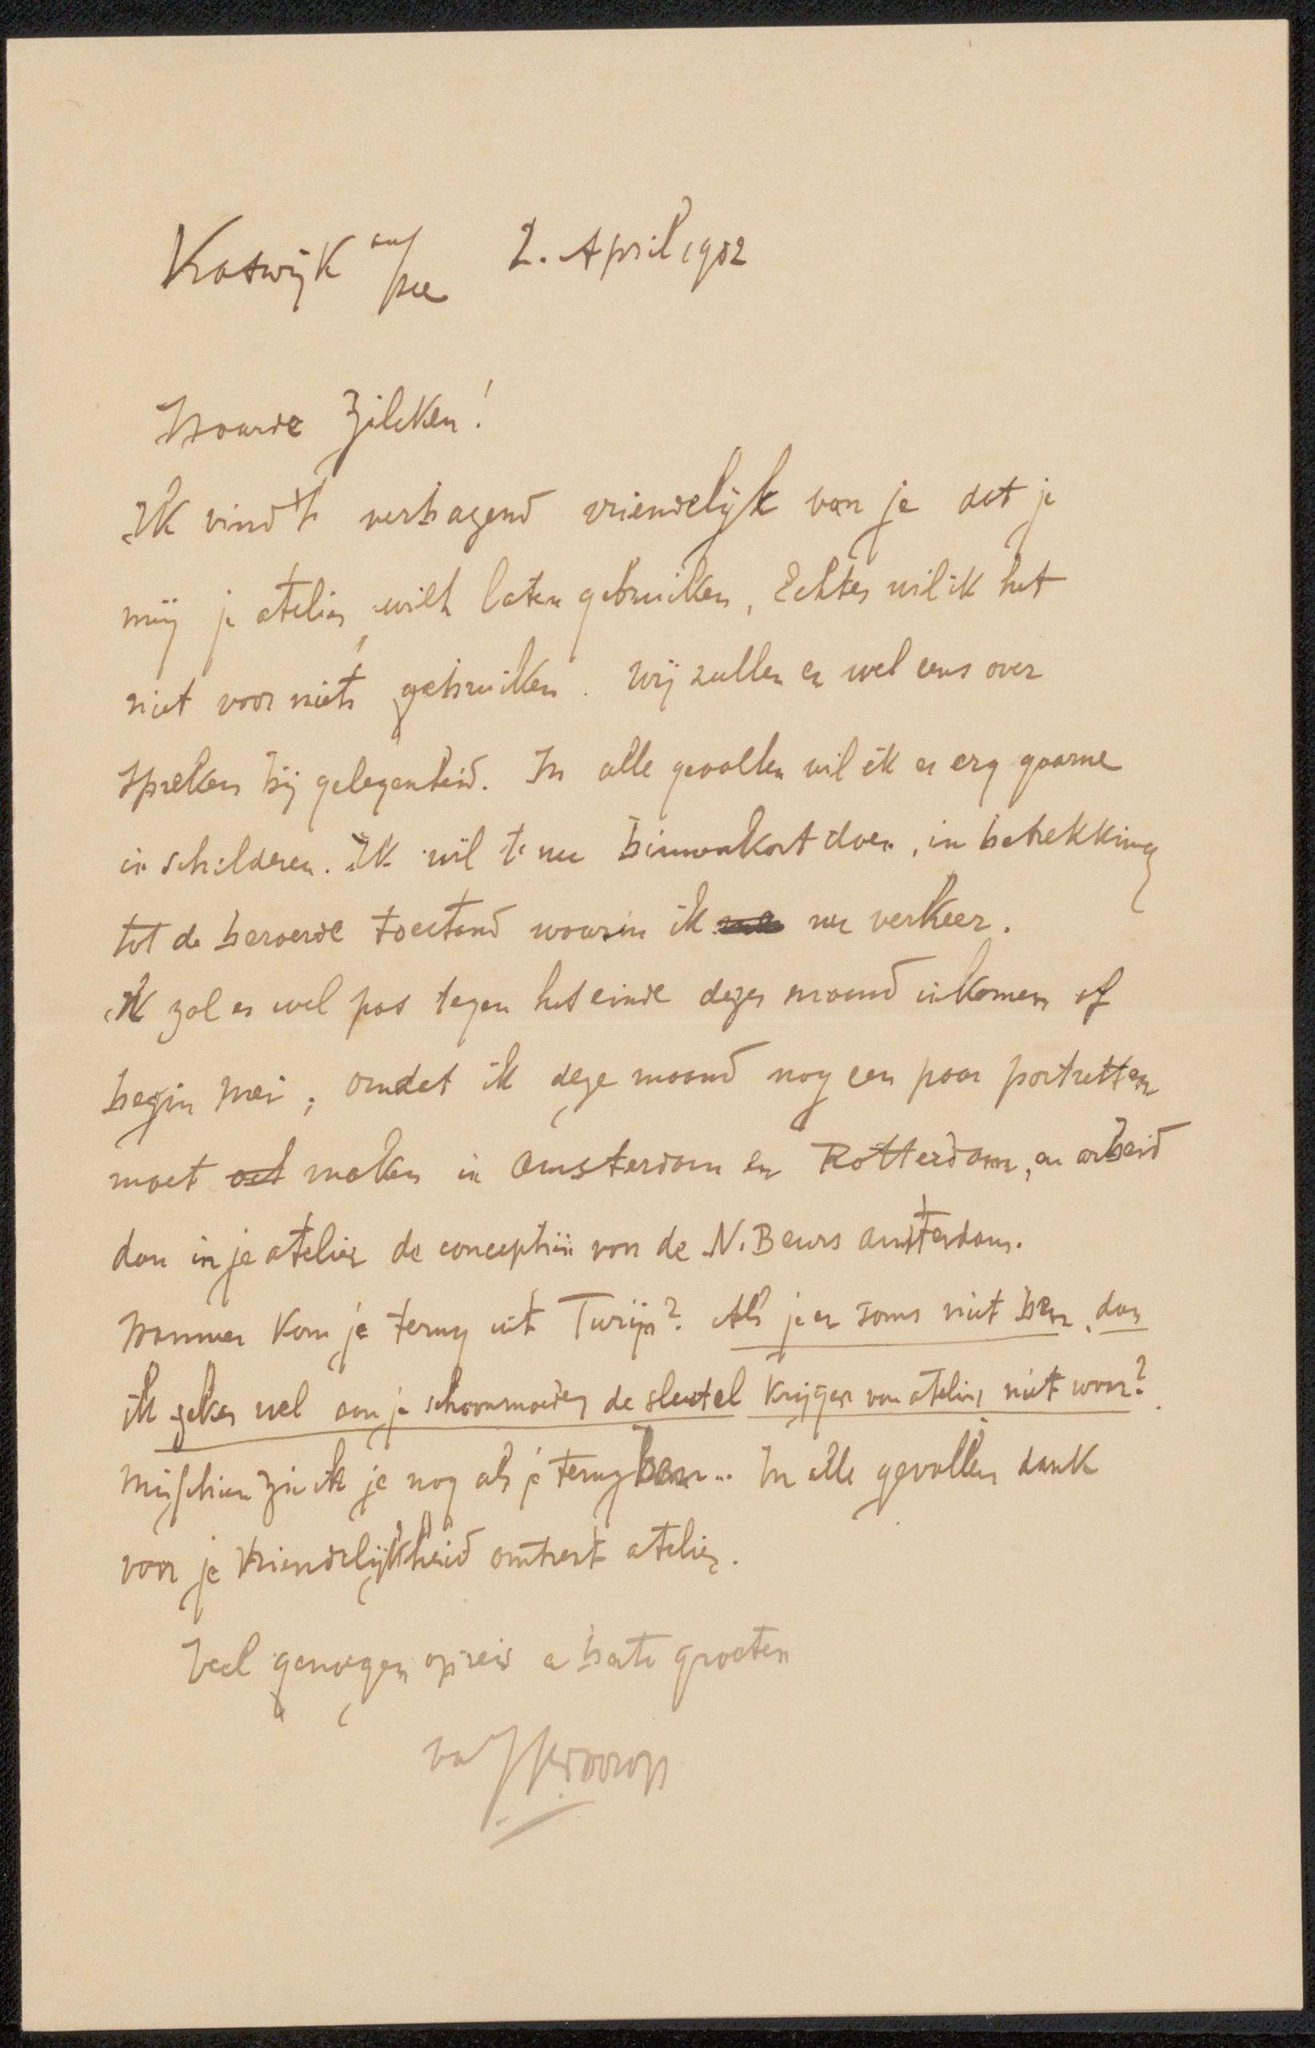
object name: letter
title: Brief aan Philip Zilcken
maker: jan toorop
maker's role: draughtsman, painter, print maker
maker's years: 1858-1928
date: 1902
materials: ink, paper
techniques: pen, writing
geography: katwijk aan zee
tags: the hague, painter, draughtsman, philip zilcken, workshop, studio of the artist (in general), historical persons (portraits and scenes from the life), rotterdam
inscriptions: collector's mark: ‘RPK’